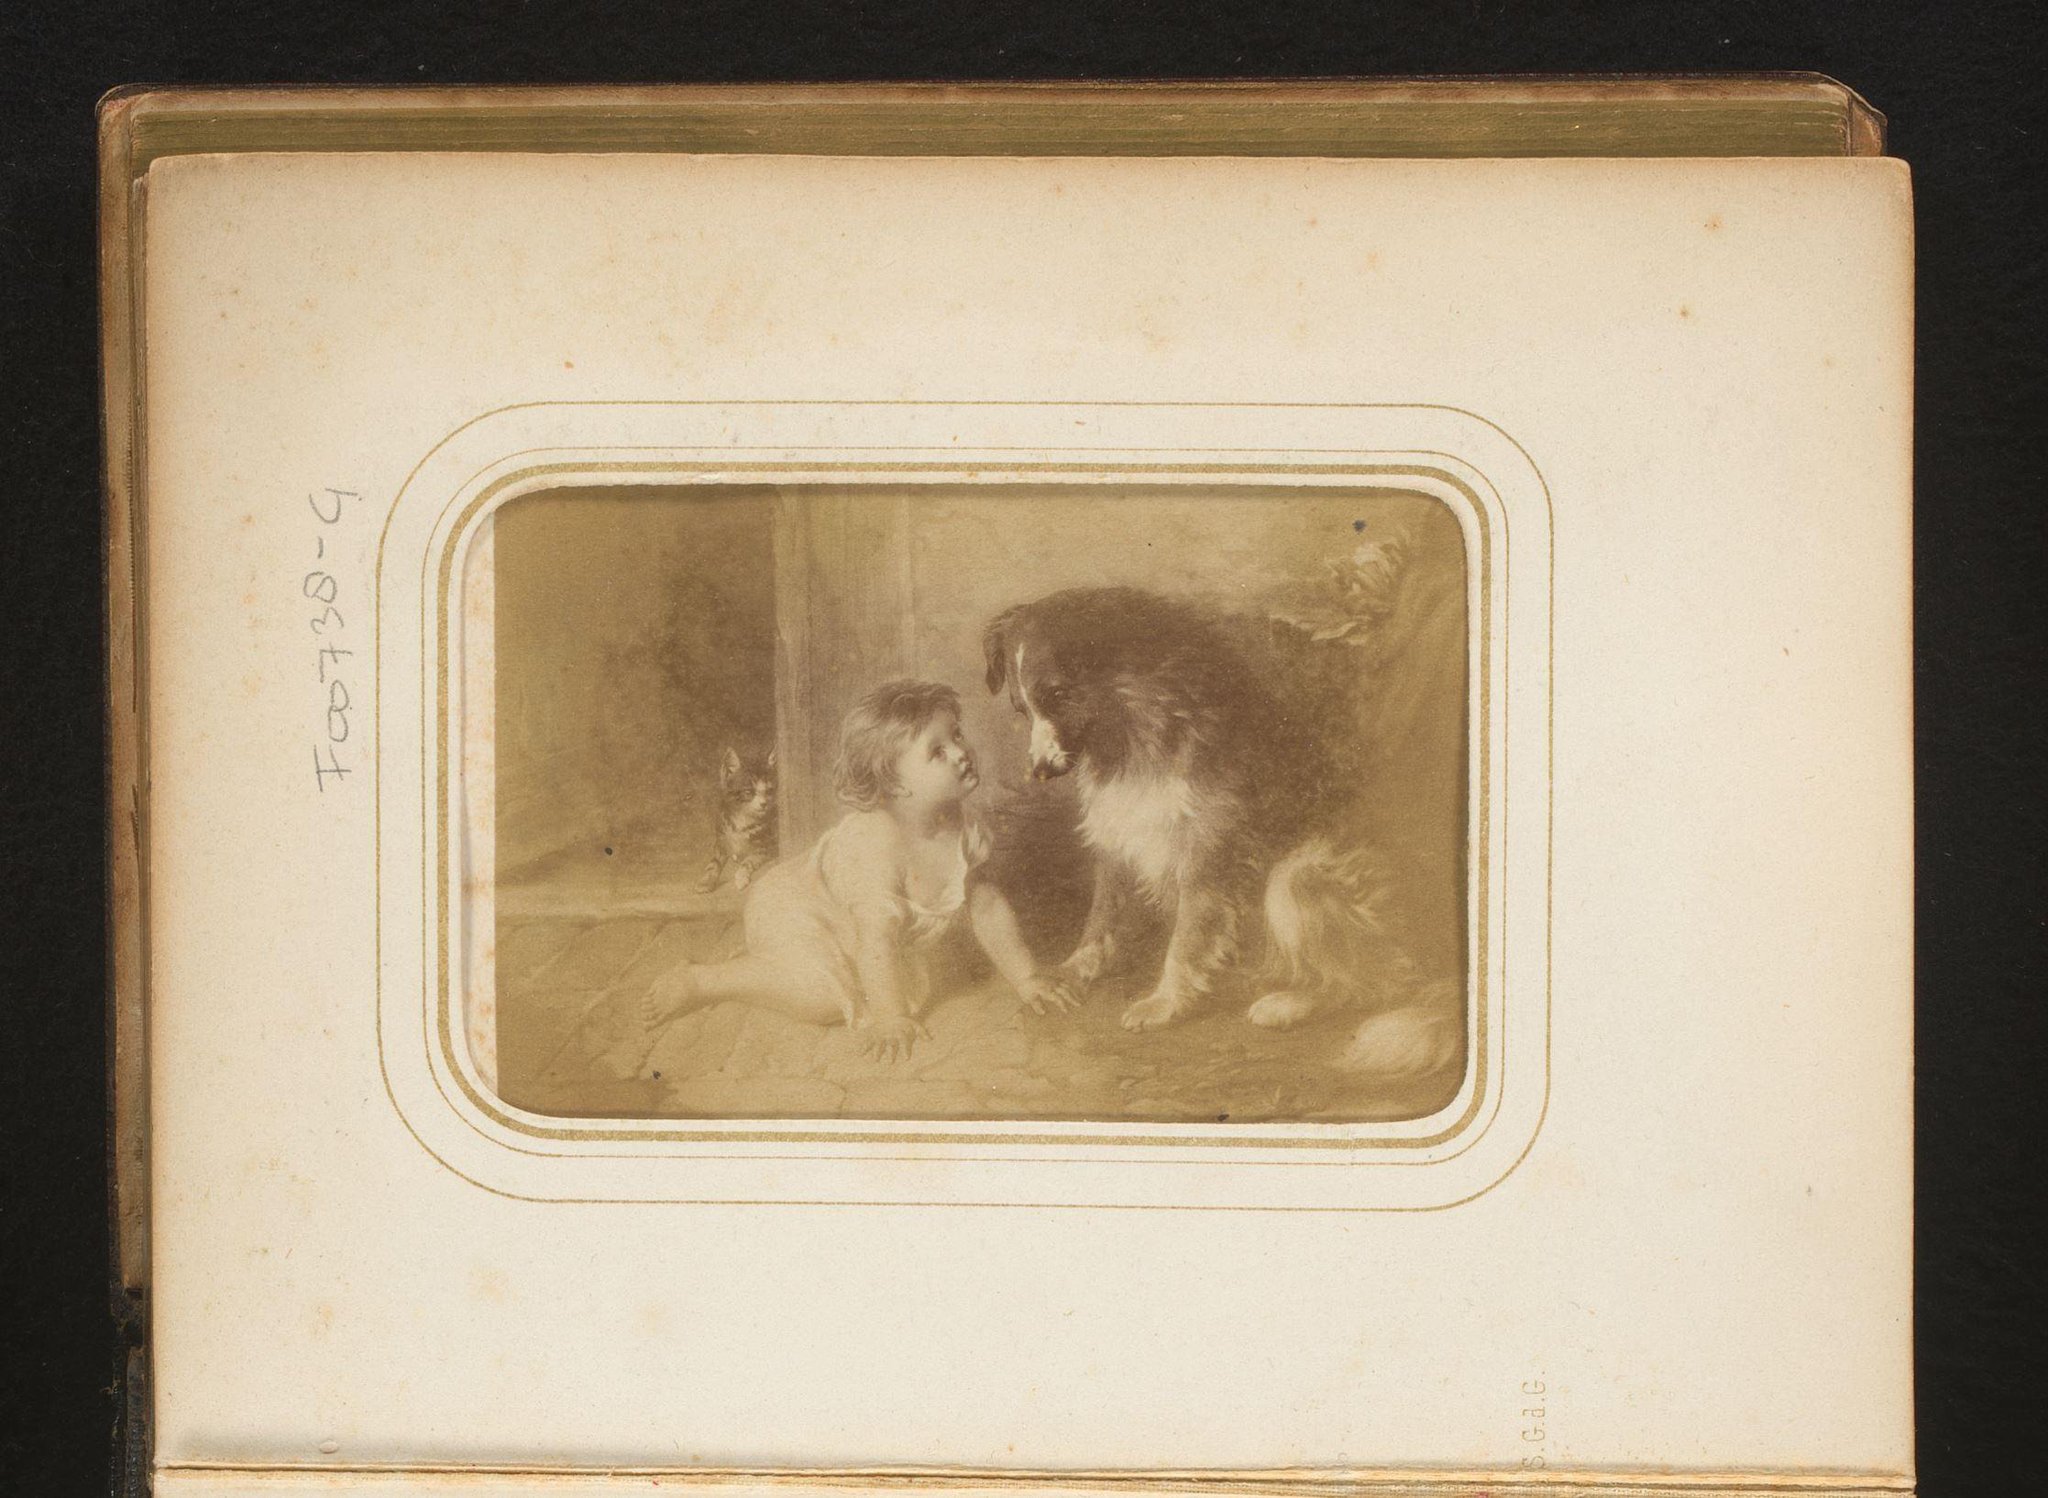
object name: reproduction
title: Fotoreproductie van een schilderij van een peuter en een hond door George Augustus Holmes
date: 1870-1890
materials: cardboard, photographic support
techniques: albumen print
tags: toddler (female), dog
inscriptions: inscription: ‘309 G. A. HOLMES./ "Can't you talk?"’, inscription: ‘Breveté S.G.D.G.’